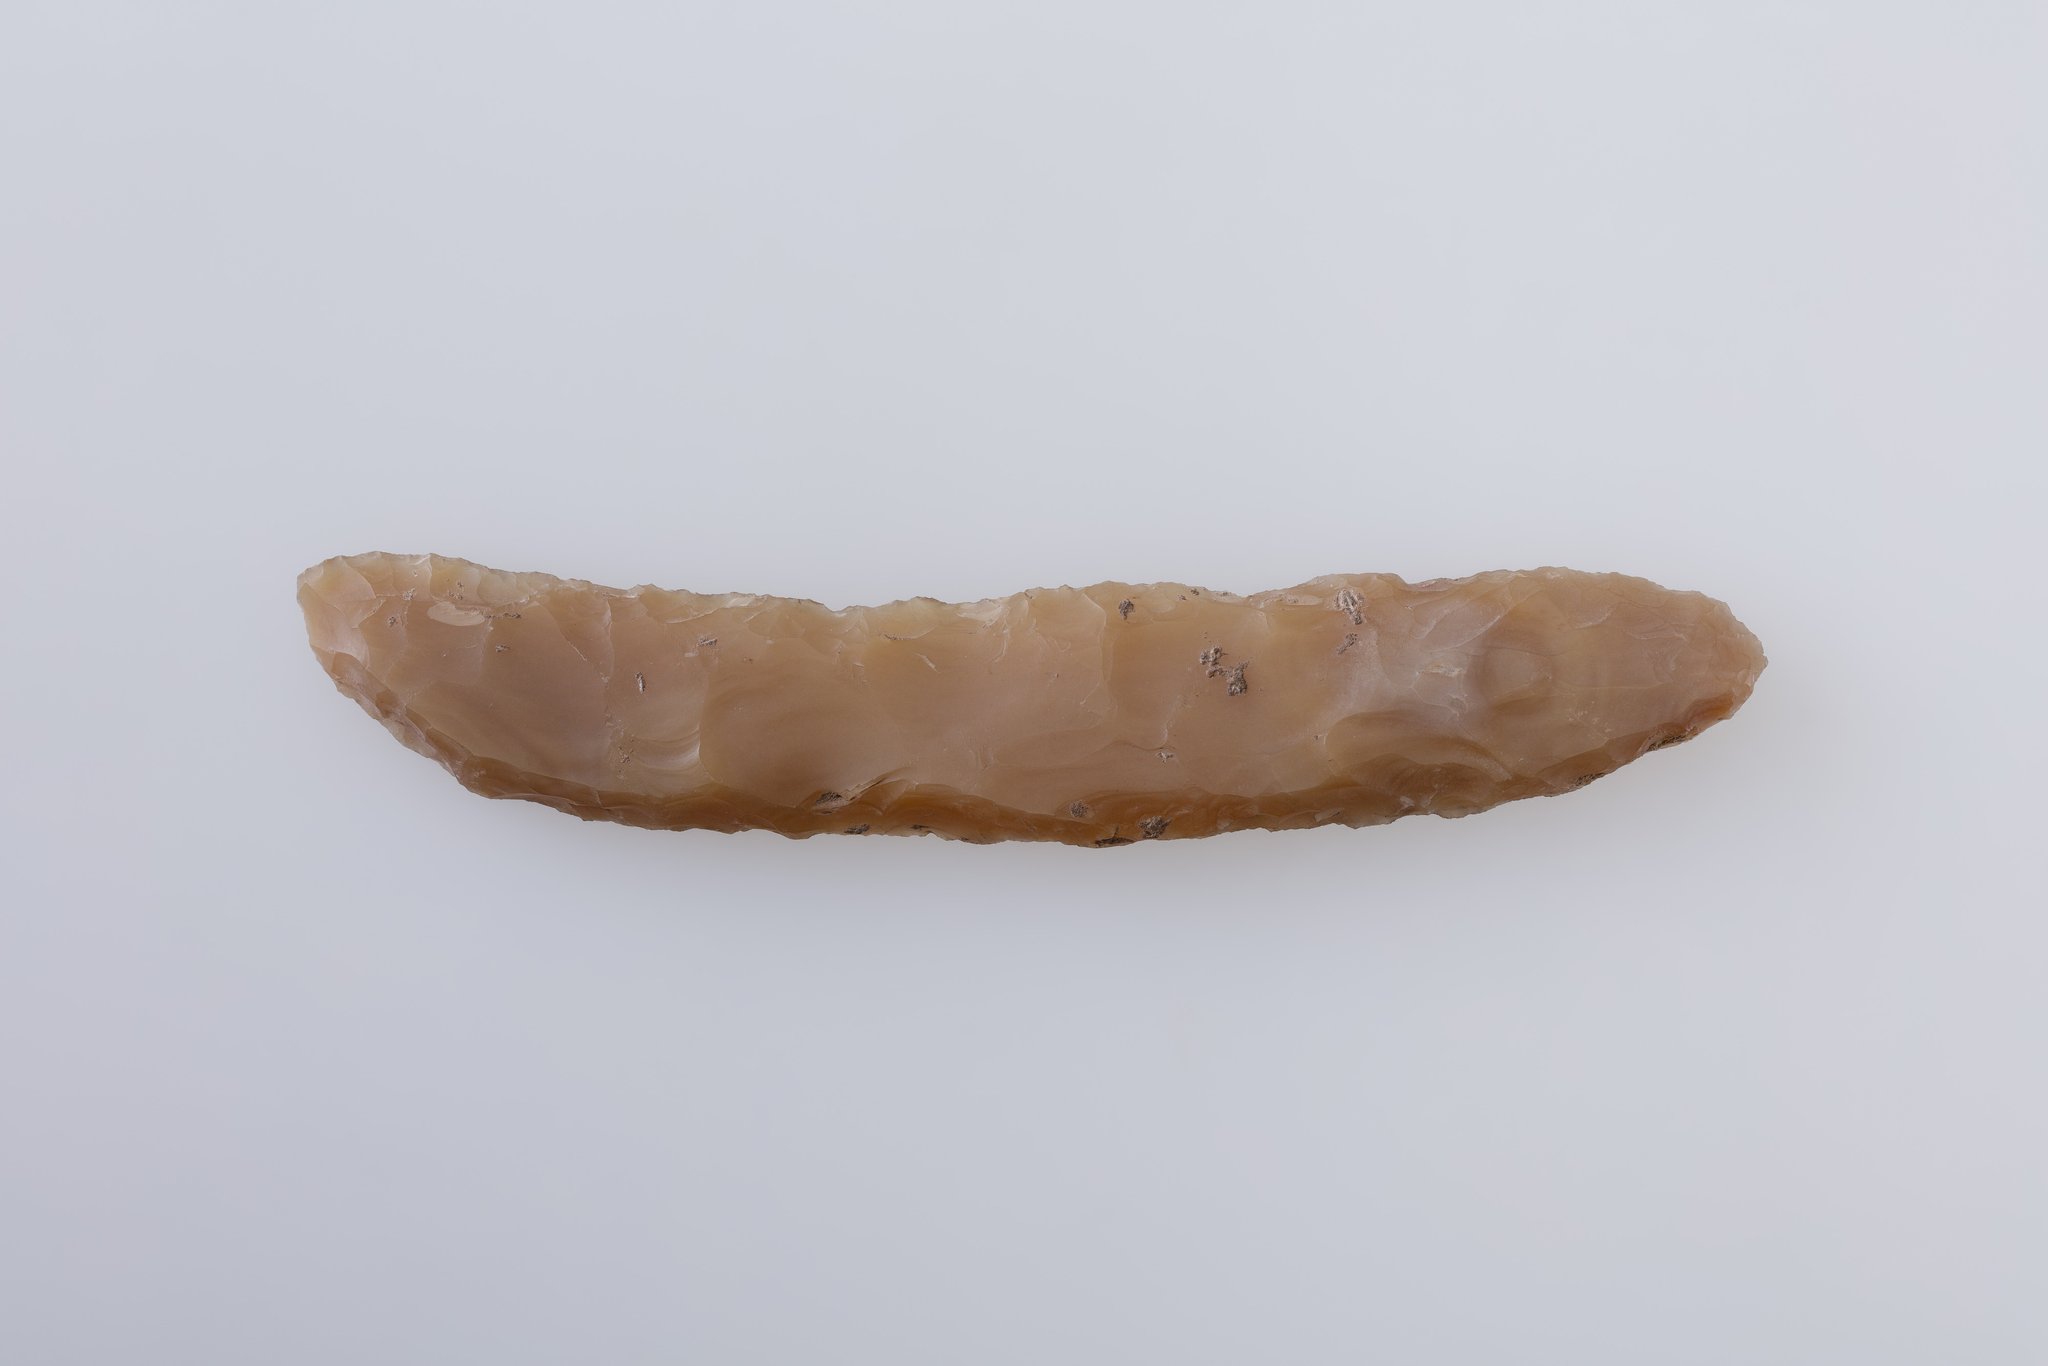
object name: tool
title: Bifacial Knife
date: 3100-2649 BCE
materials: stone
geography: egypt